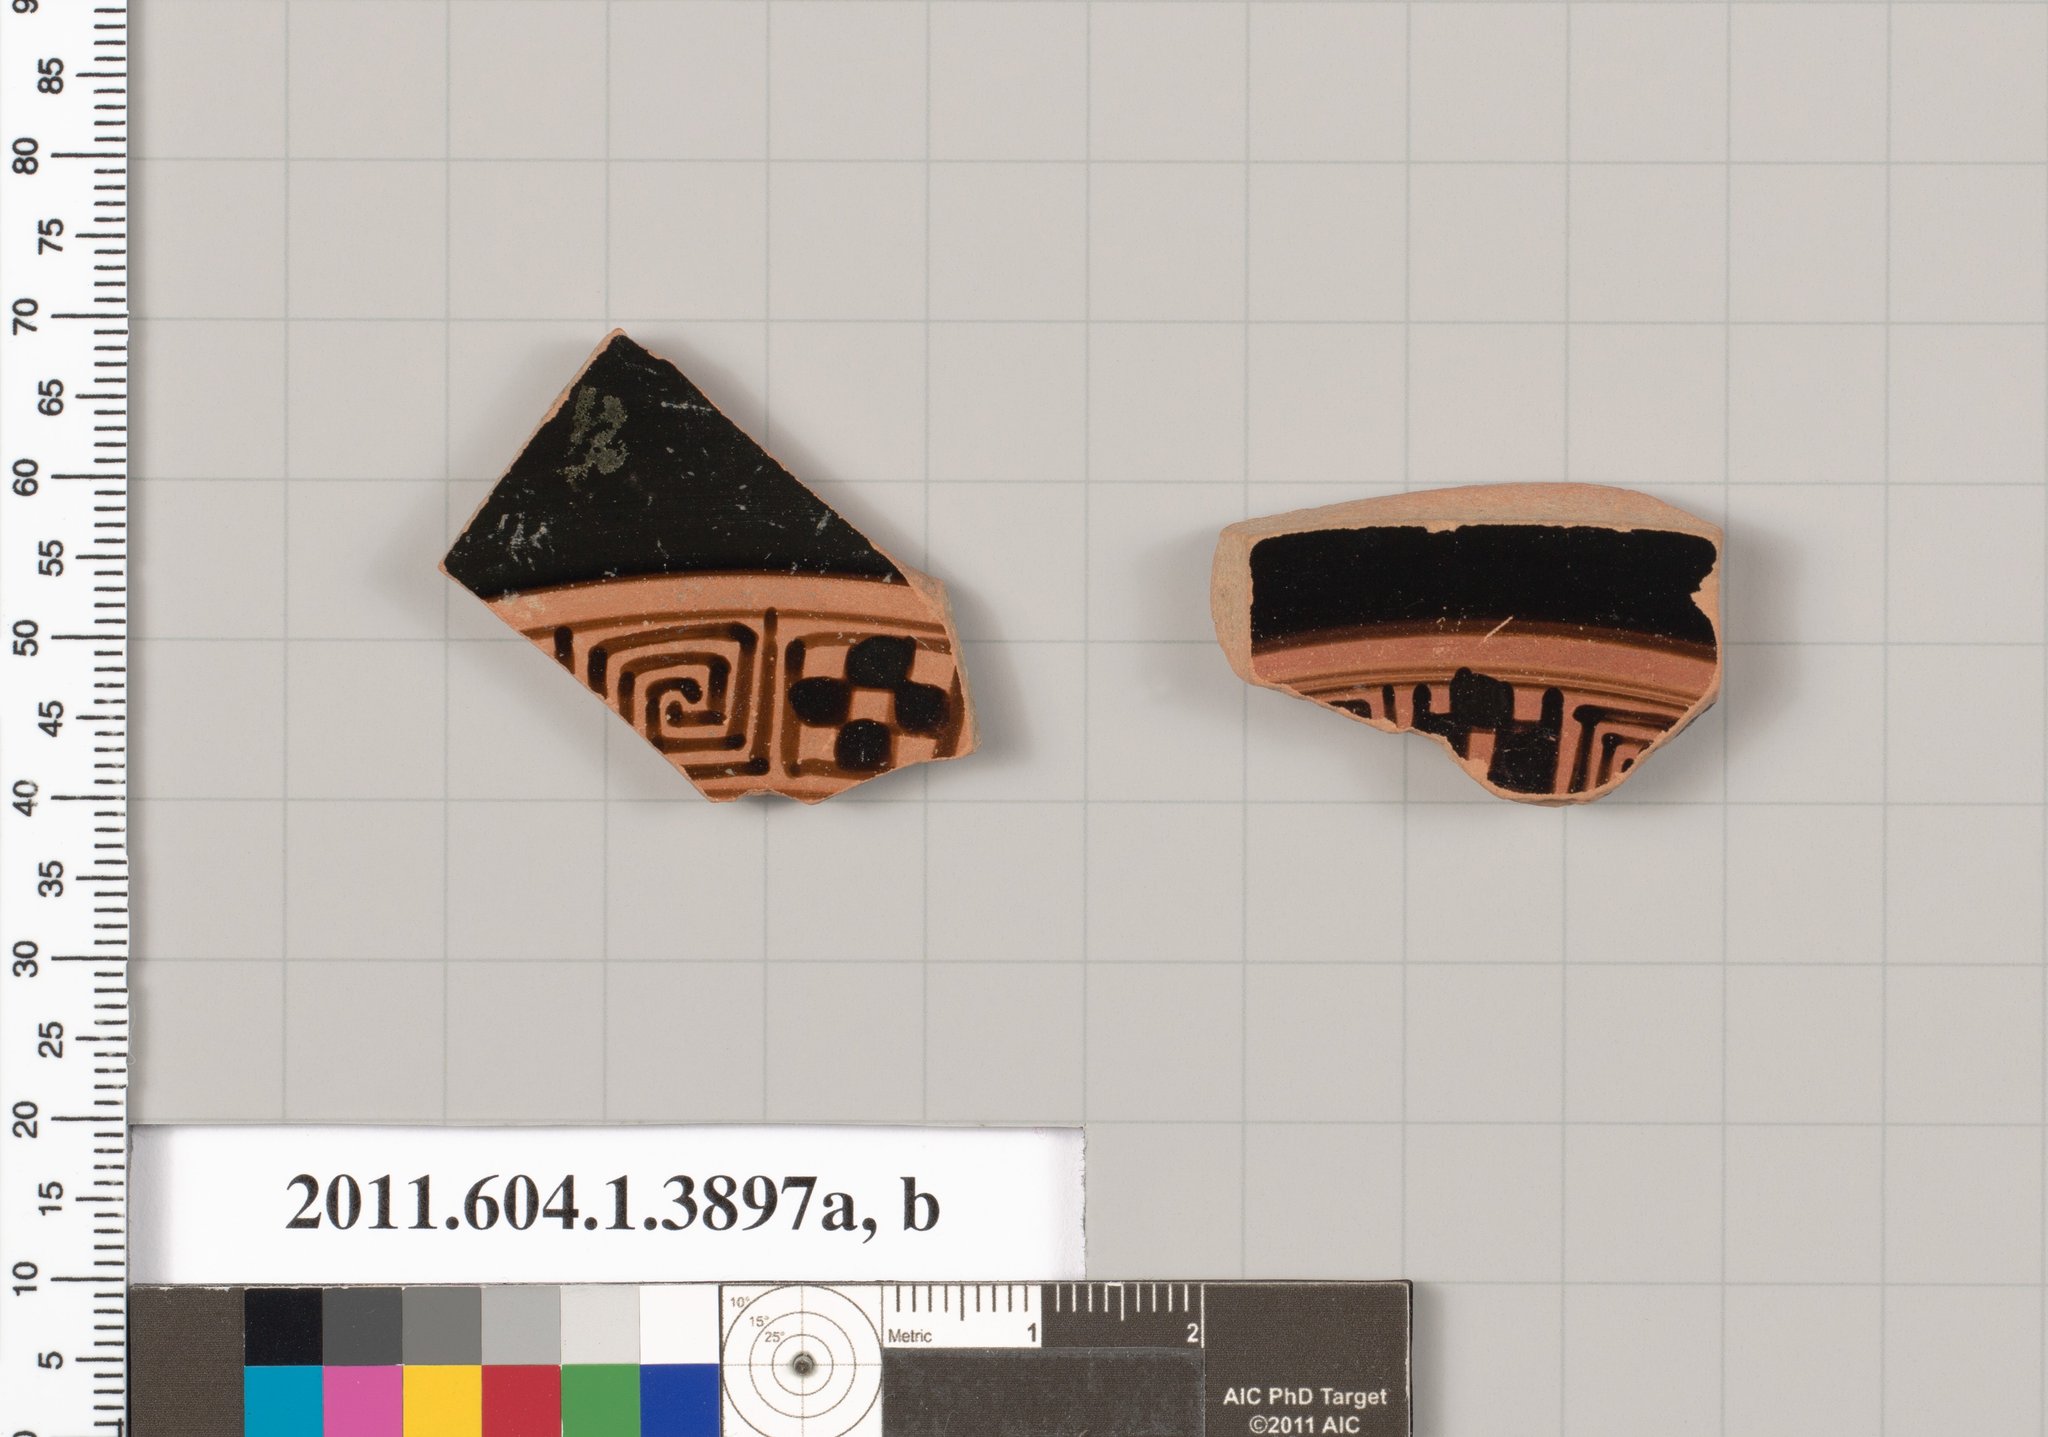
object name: kylix fragment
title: Terracotta fragments of kylikes (drinking cups)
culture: greek, attic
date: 475-451 BCE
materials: terracotta